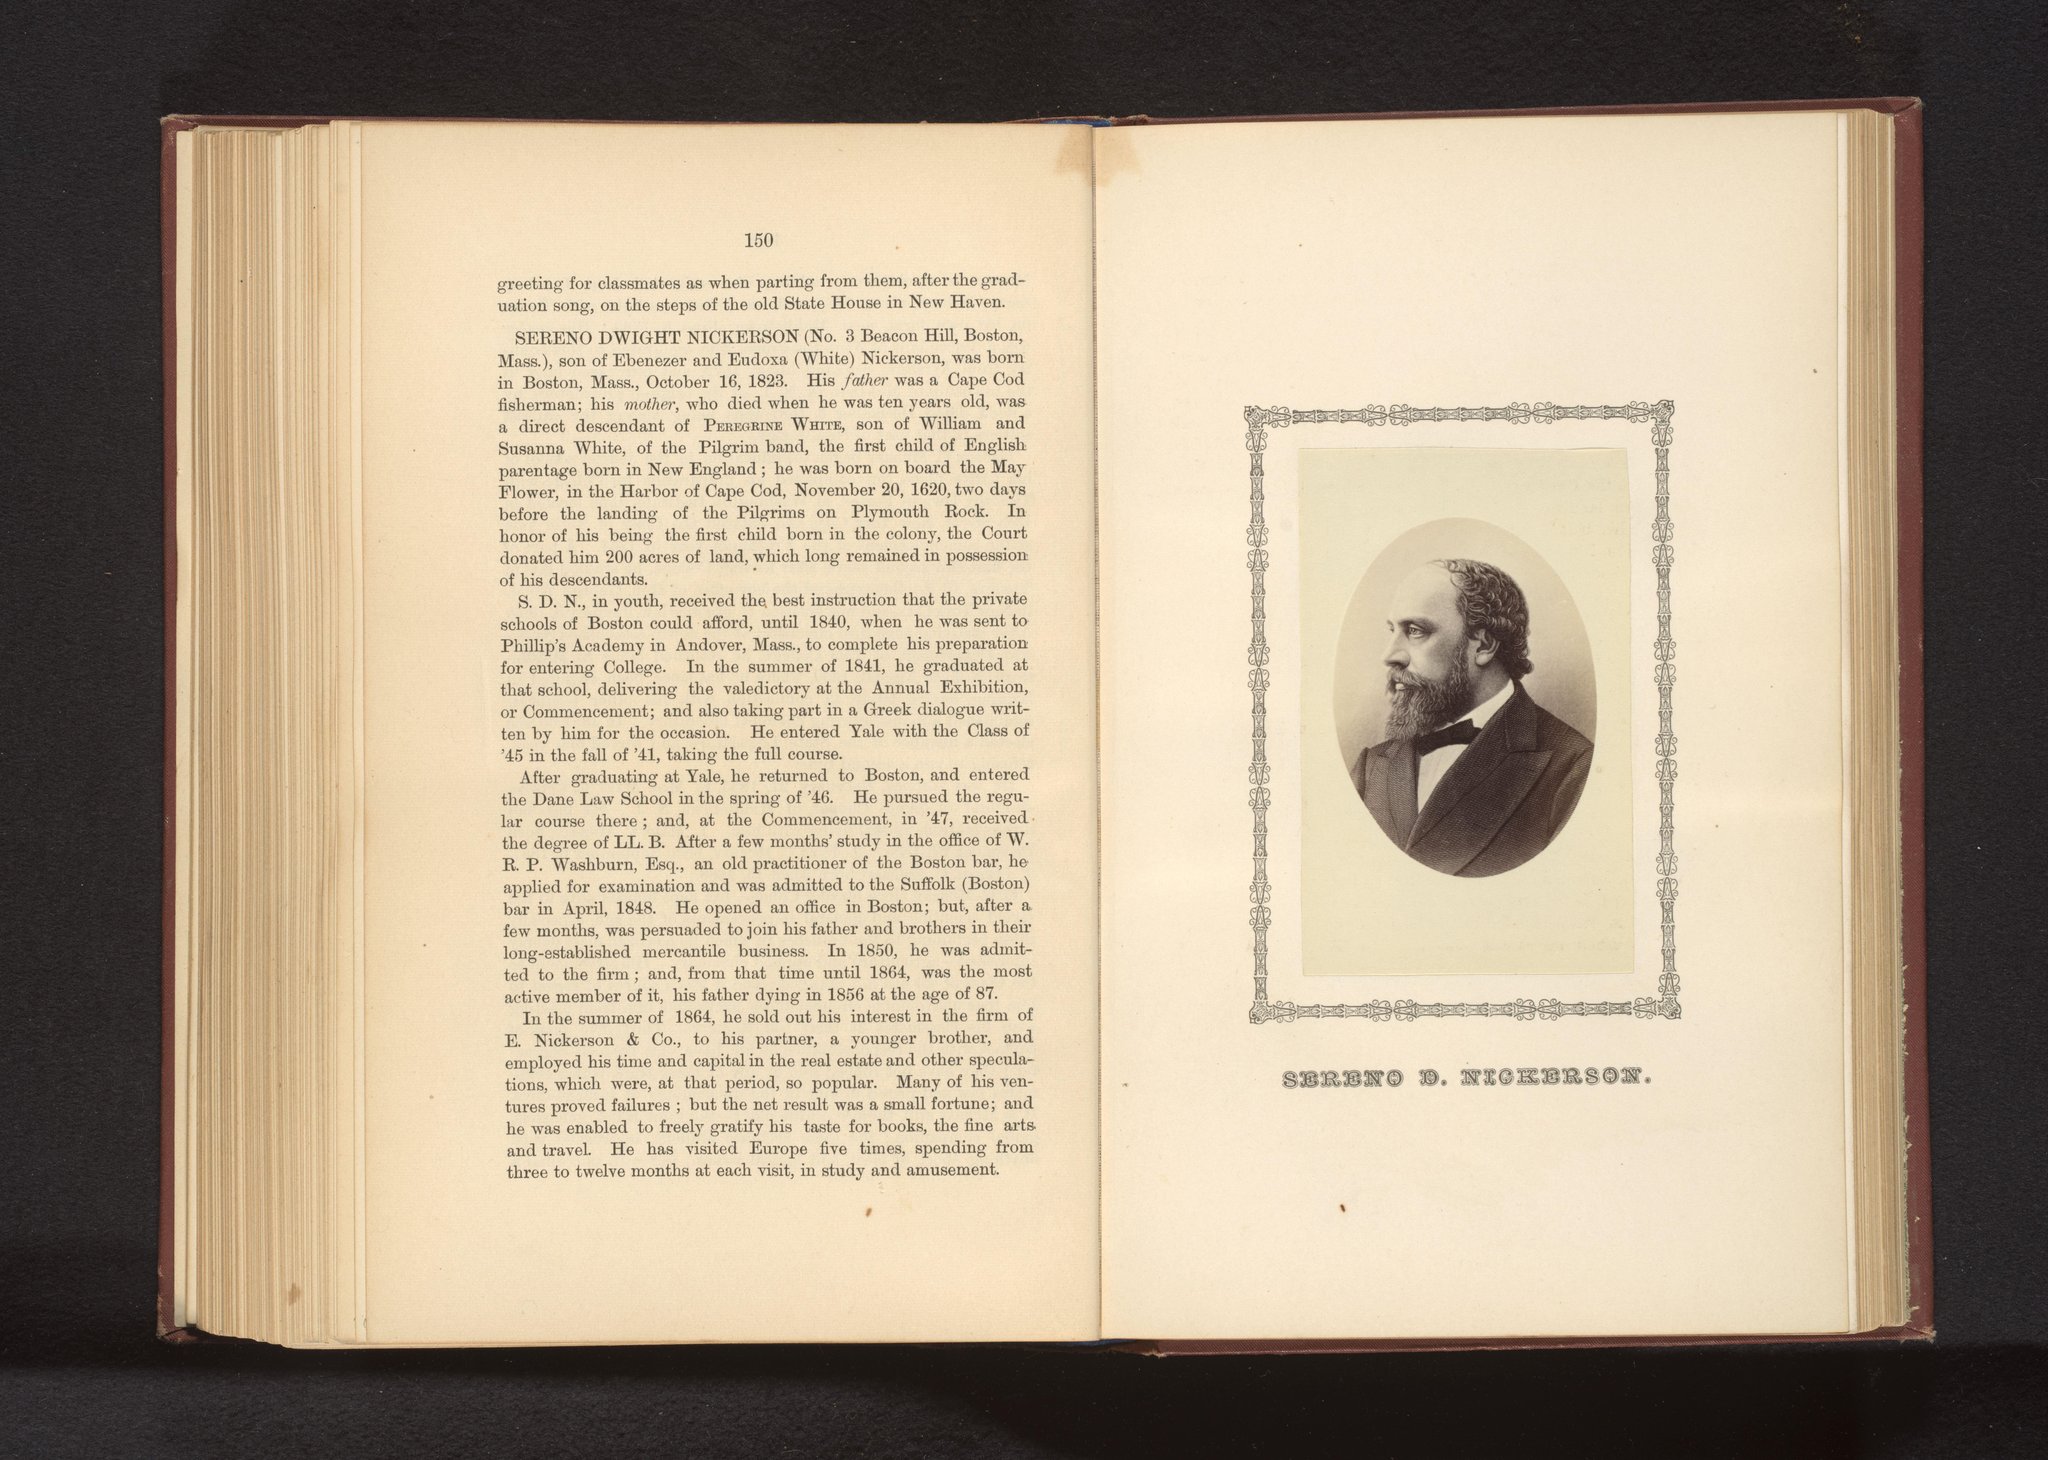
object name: photograph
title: Sereno D. Nickerson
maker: Anonymous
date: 1876-1881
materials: photographic support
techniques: albumen print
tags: adult man